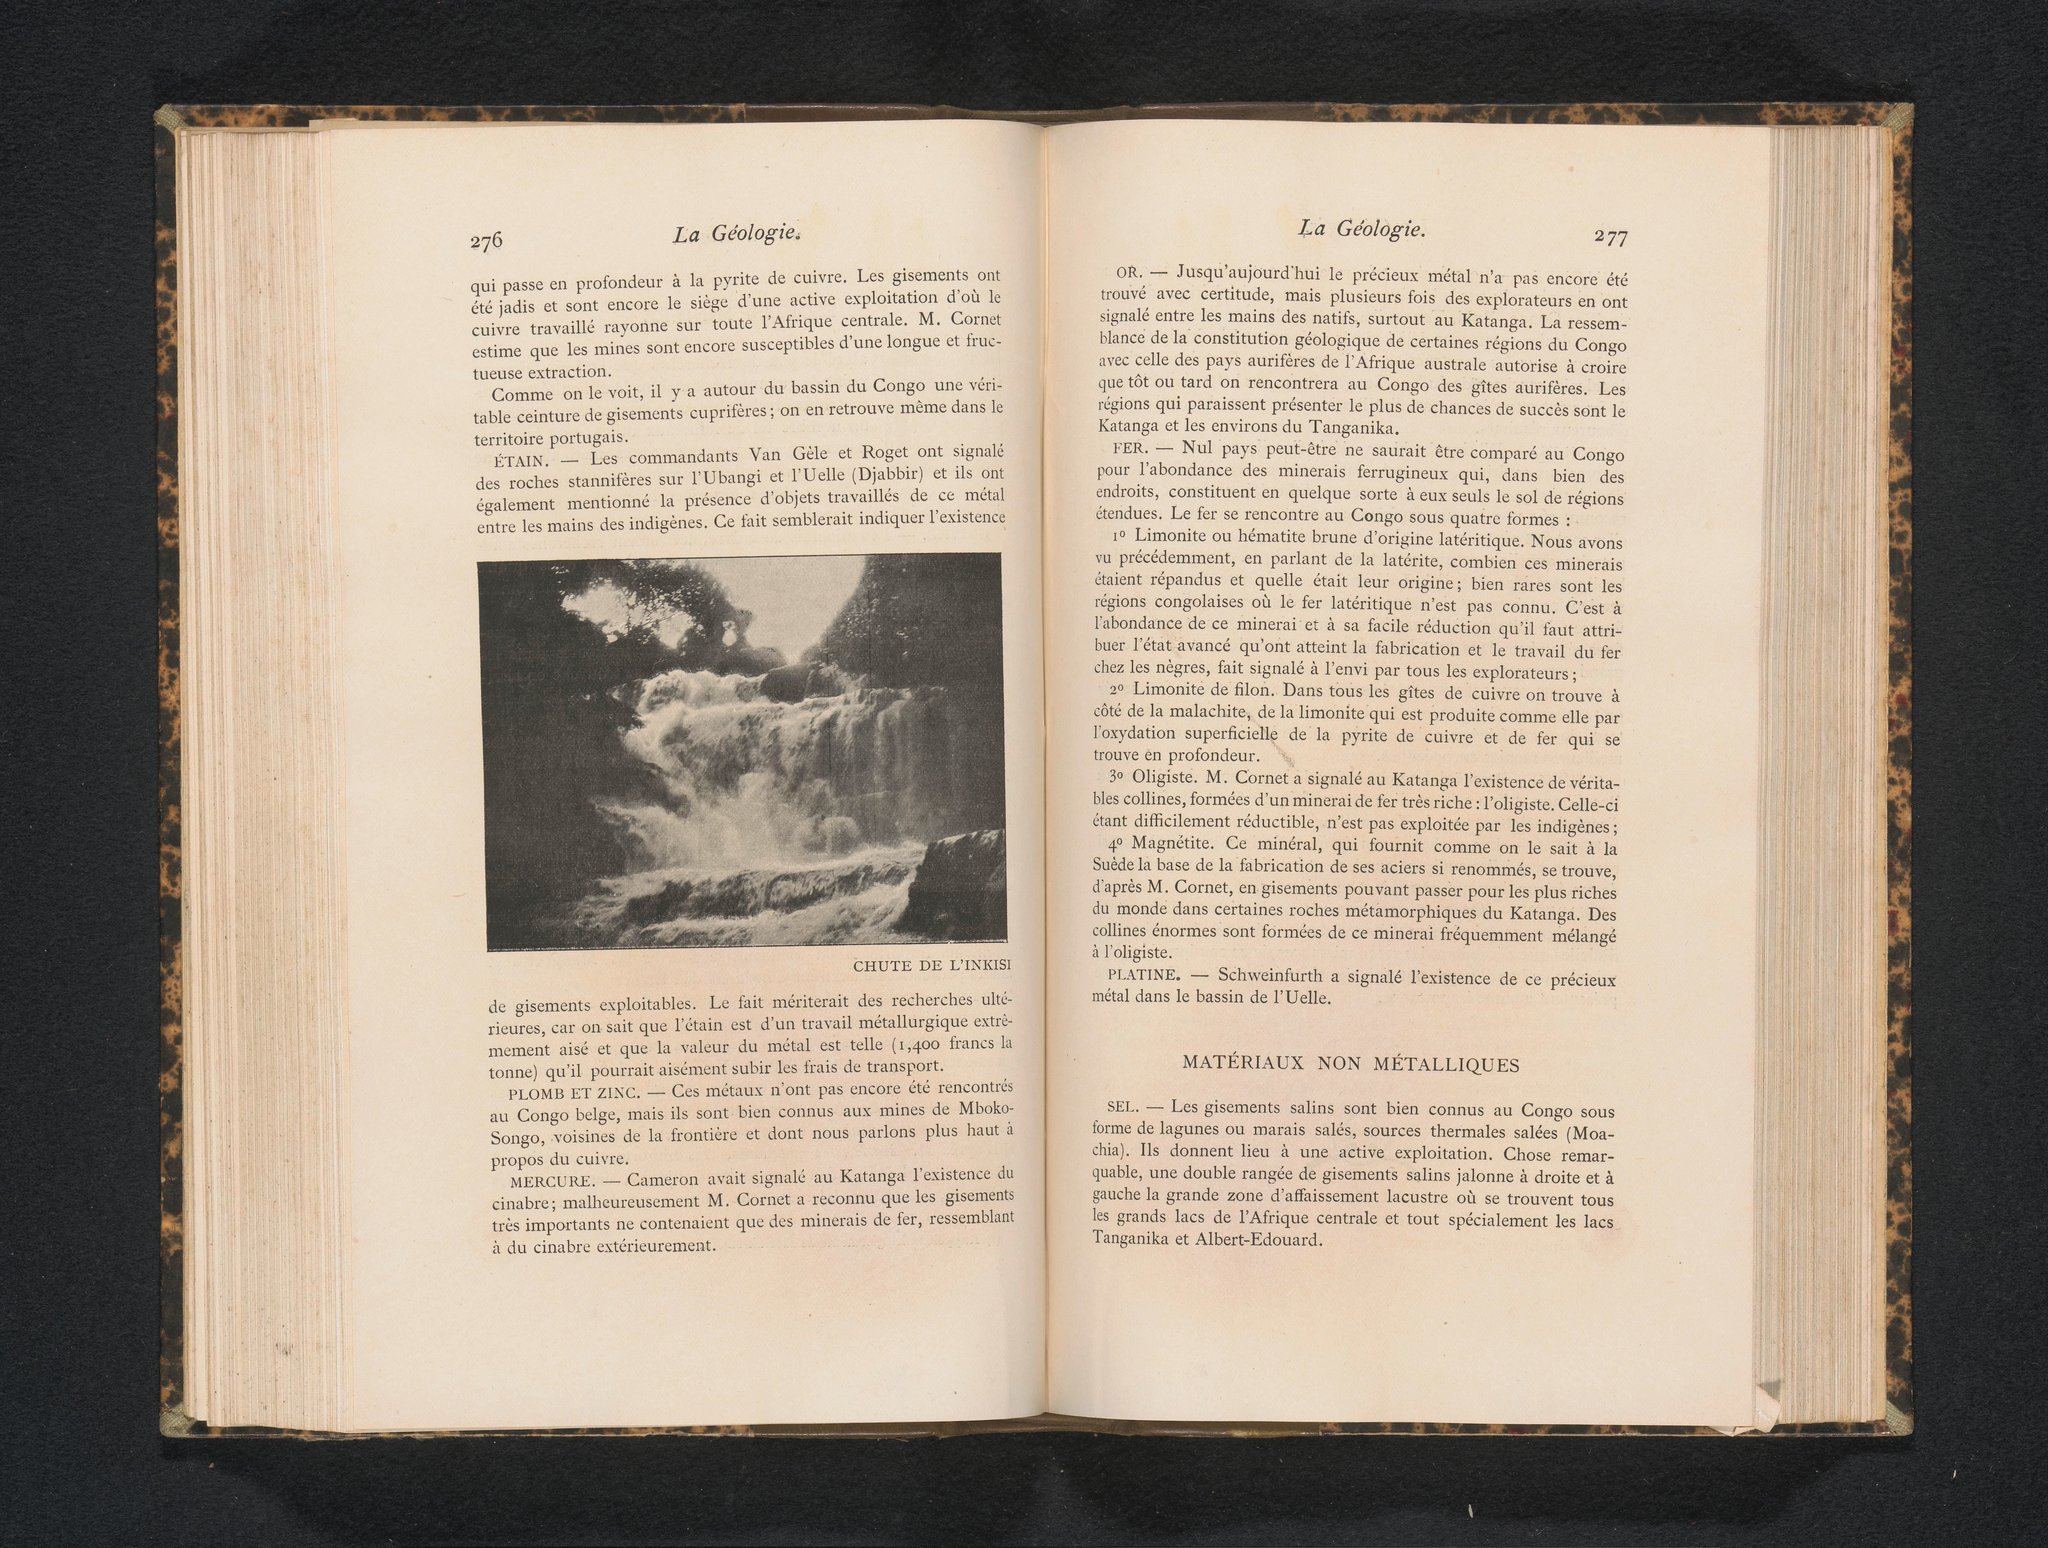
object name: photomechanical print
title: Chute de L'inkisi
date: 1887-1892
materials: paper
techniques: autotype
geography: congo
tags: rapids, river